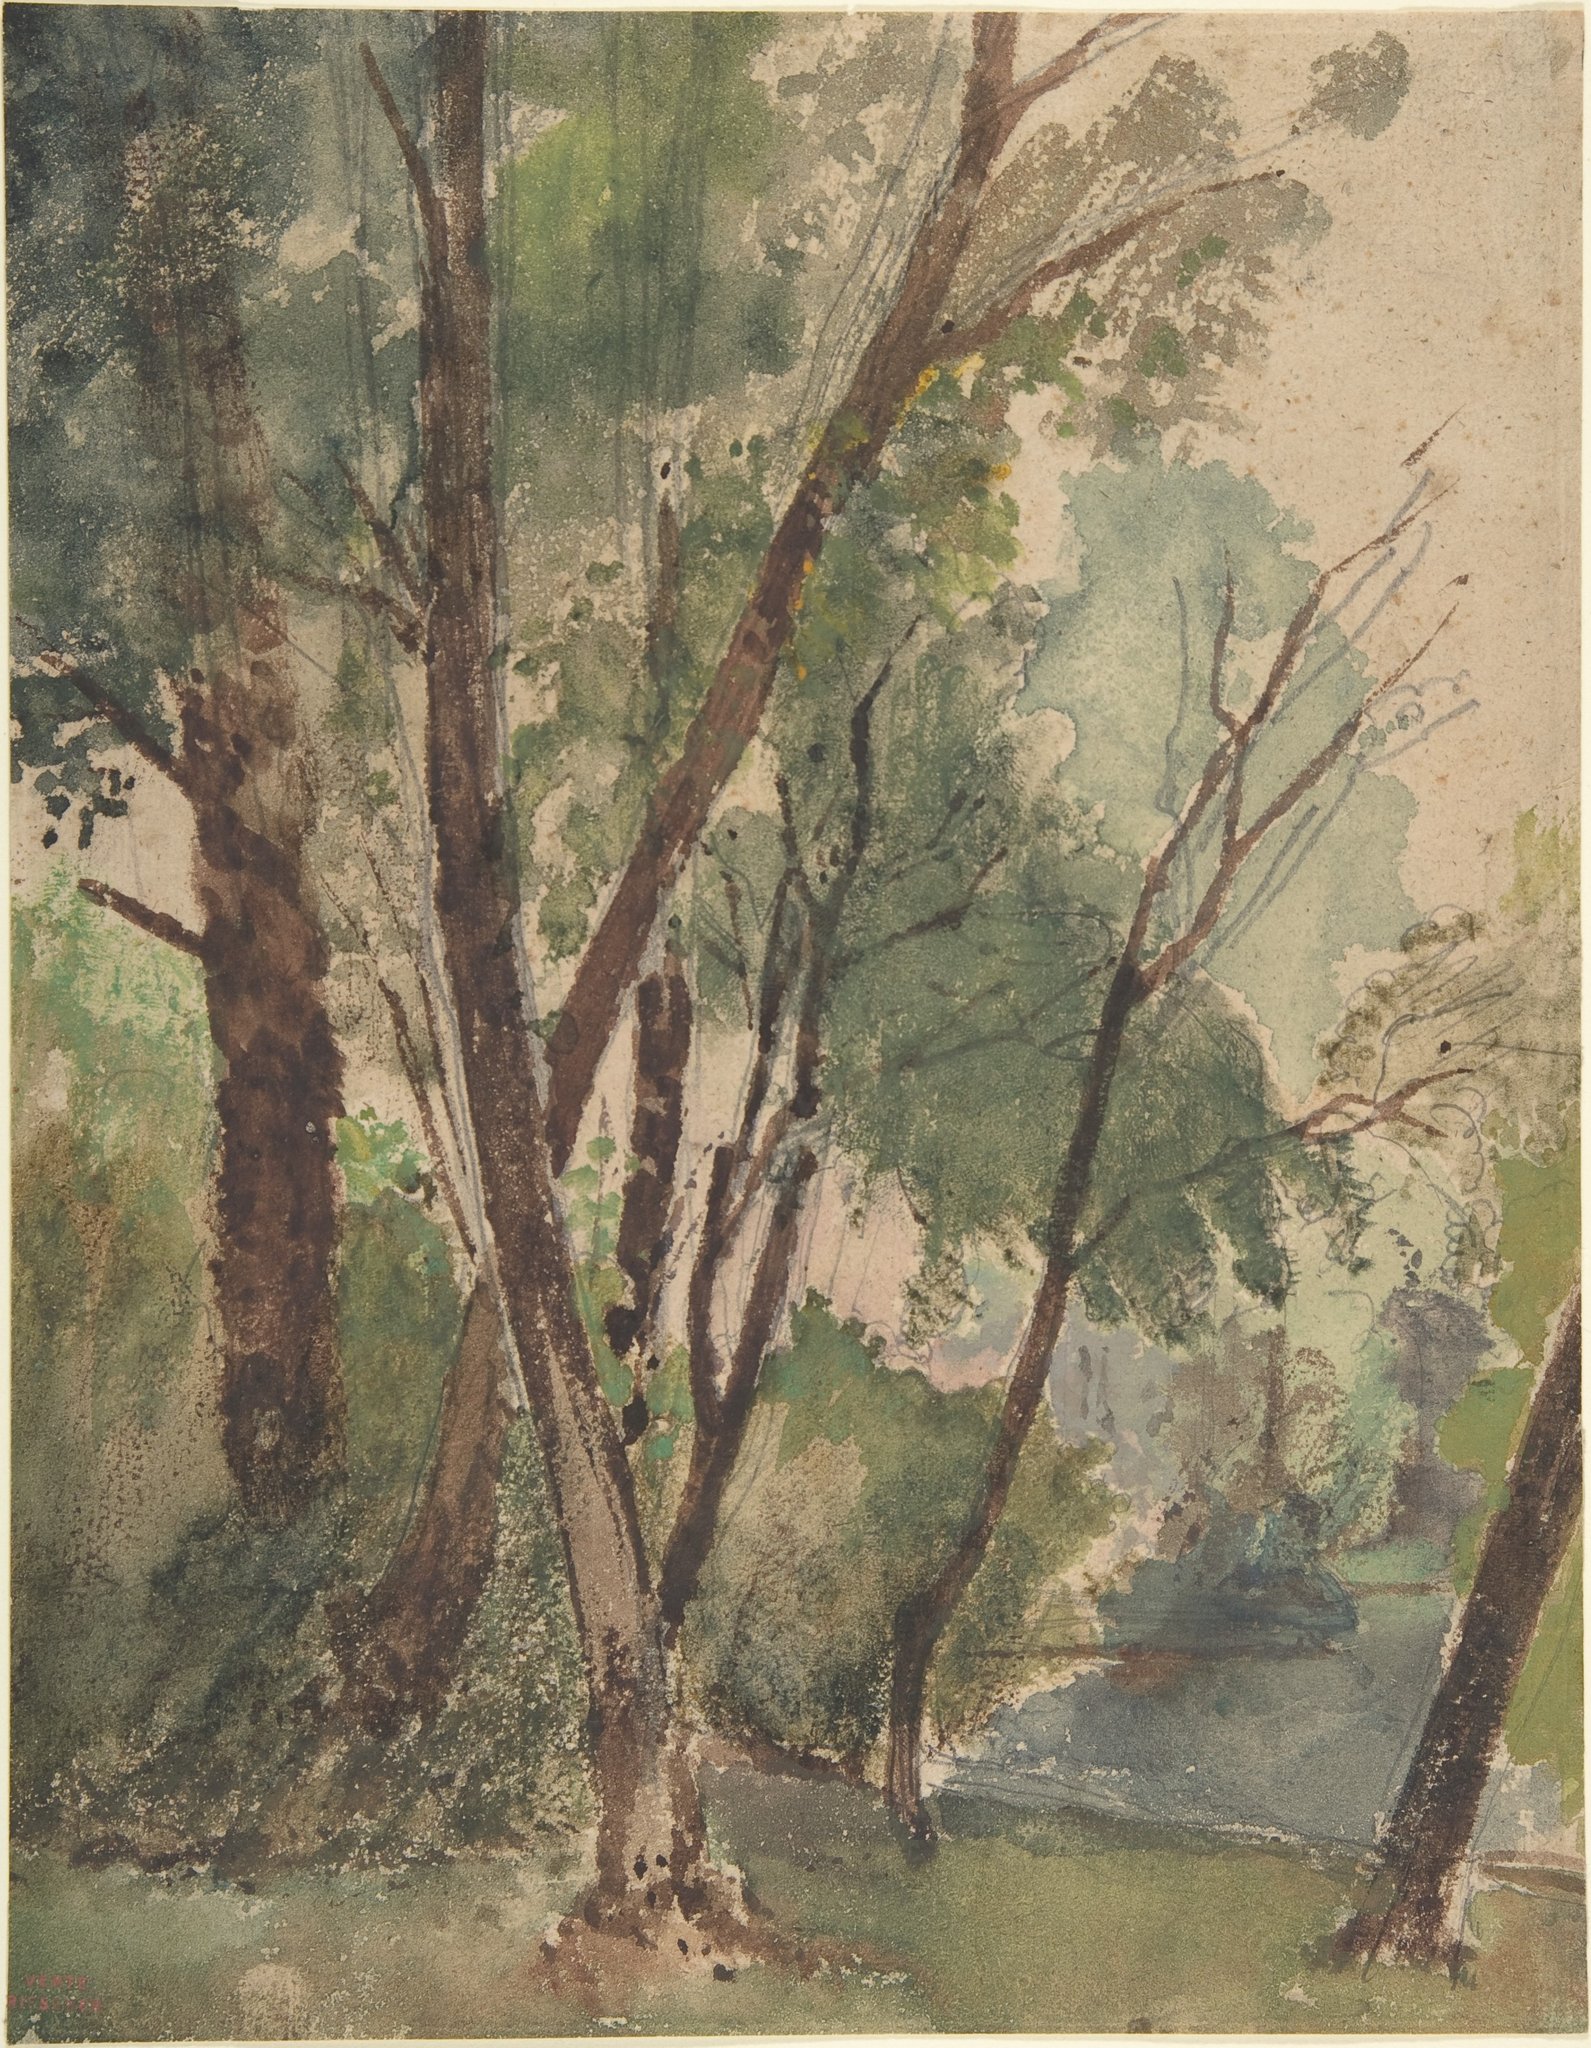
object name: drawing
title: Trees Beside a Pond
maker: louis-antoine-léon riesener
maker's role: artist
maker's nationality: french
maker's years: 1808-1878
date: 1853-1878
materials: graphite, watercolor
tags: trees